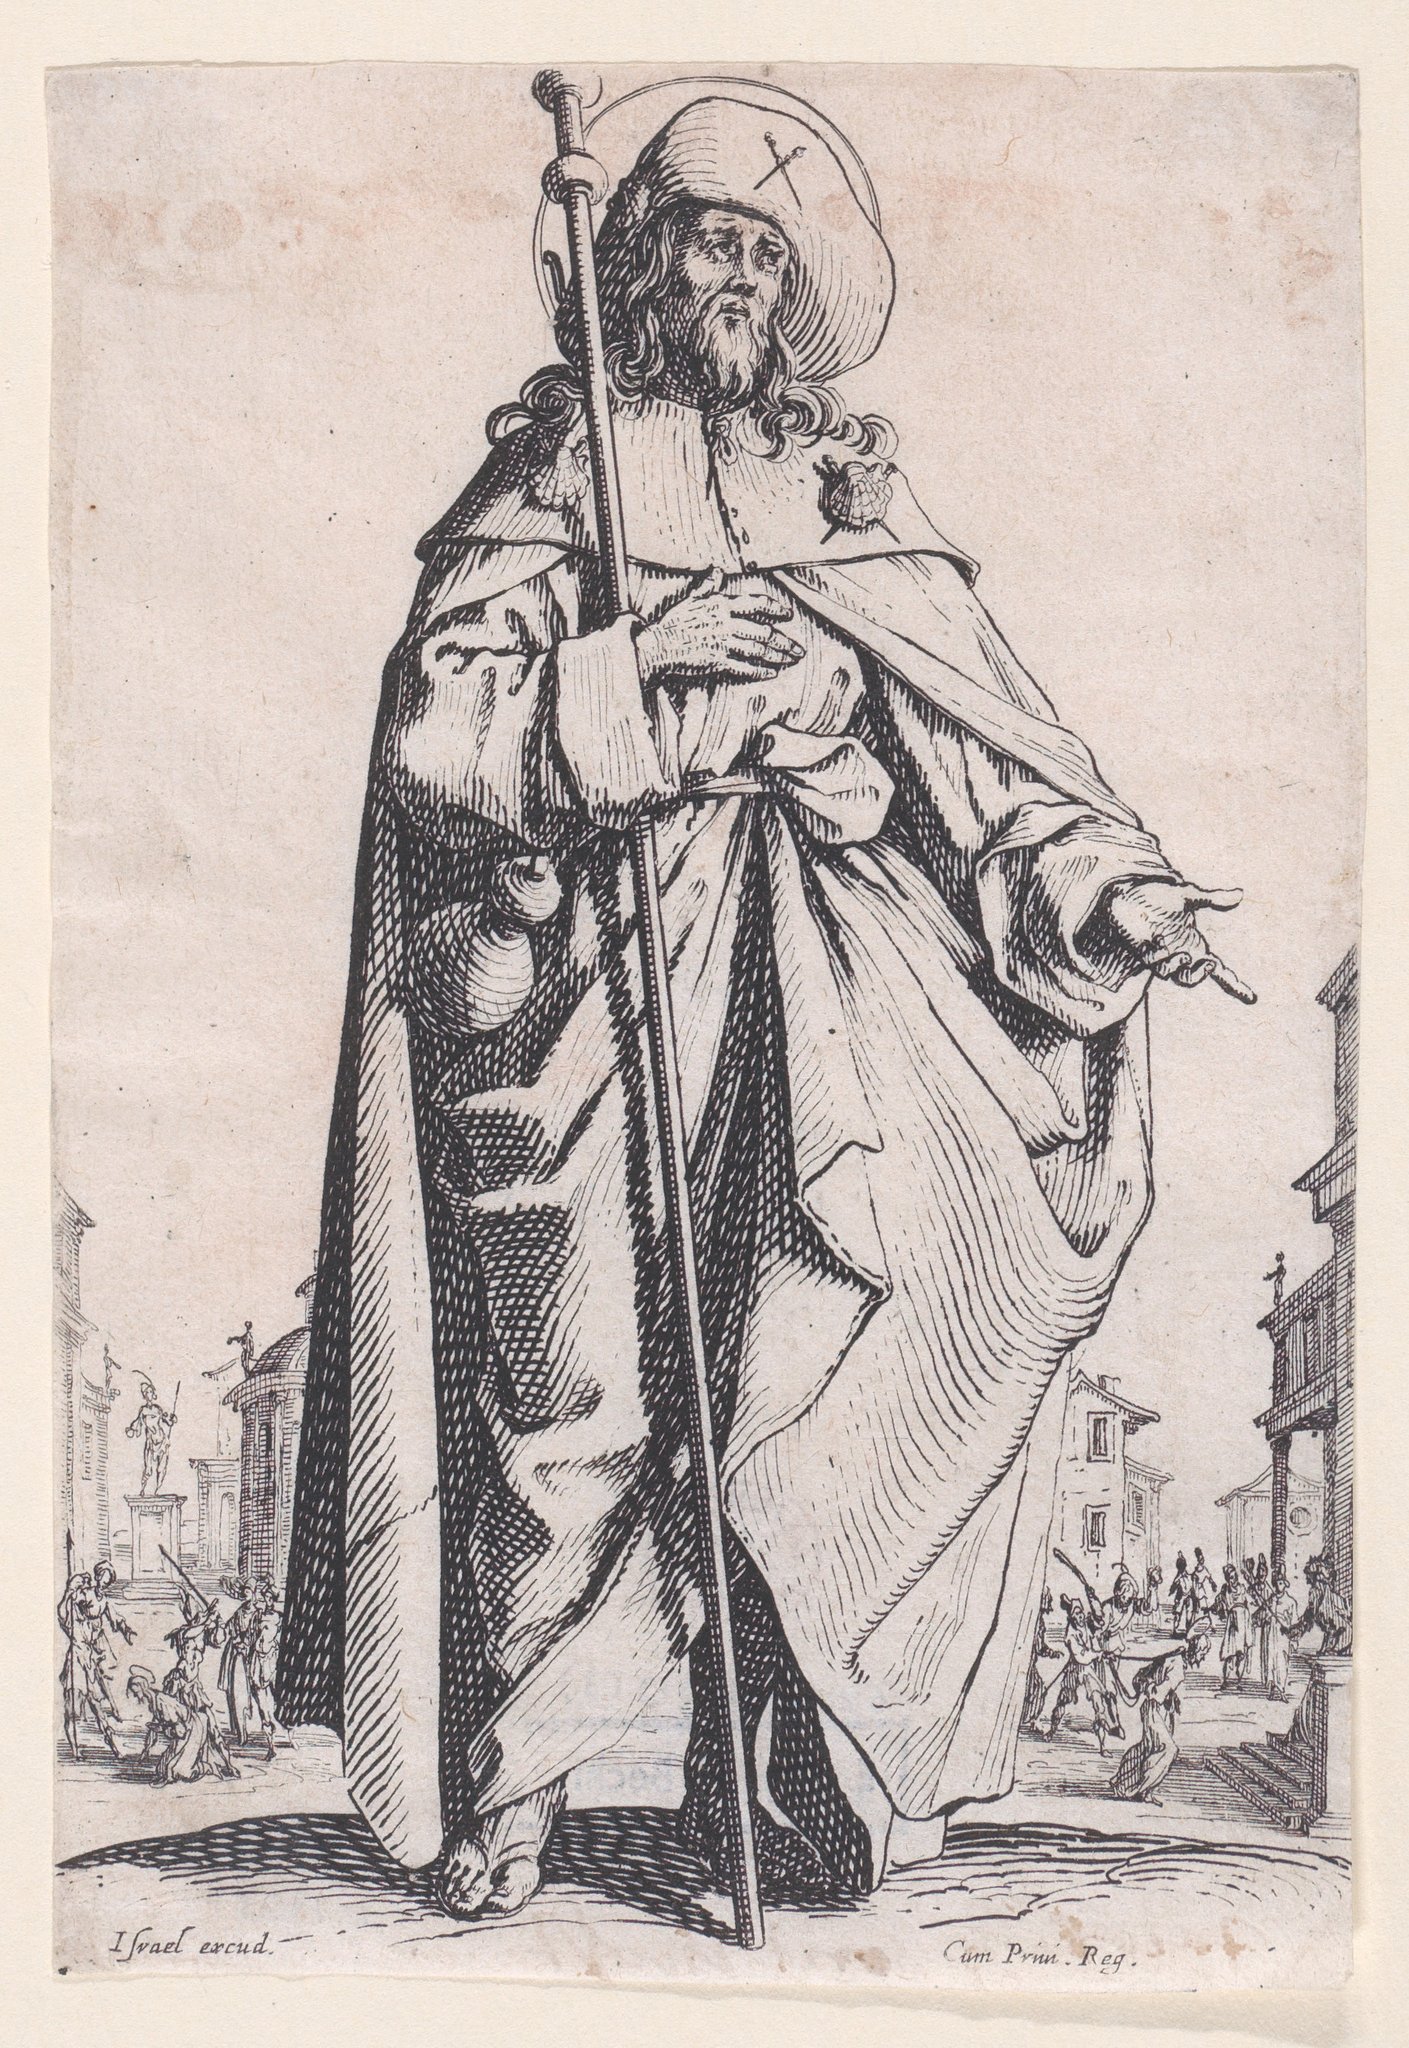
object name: print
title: St. James Major, from "Les Grands Apôtres Debout, Représentant Le Sauveur, La Bienheureuse Marie et Les Saints Apôtres" (The Large Standing Apostles, Representing The Savior, The Blessed Mary and The Apostles)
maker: jacques callot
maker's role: artist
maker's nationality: french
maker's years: 1592-1635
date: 1631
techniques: etching